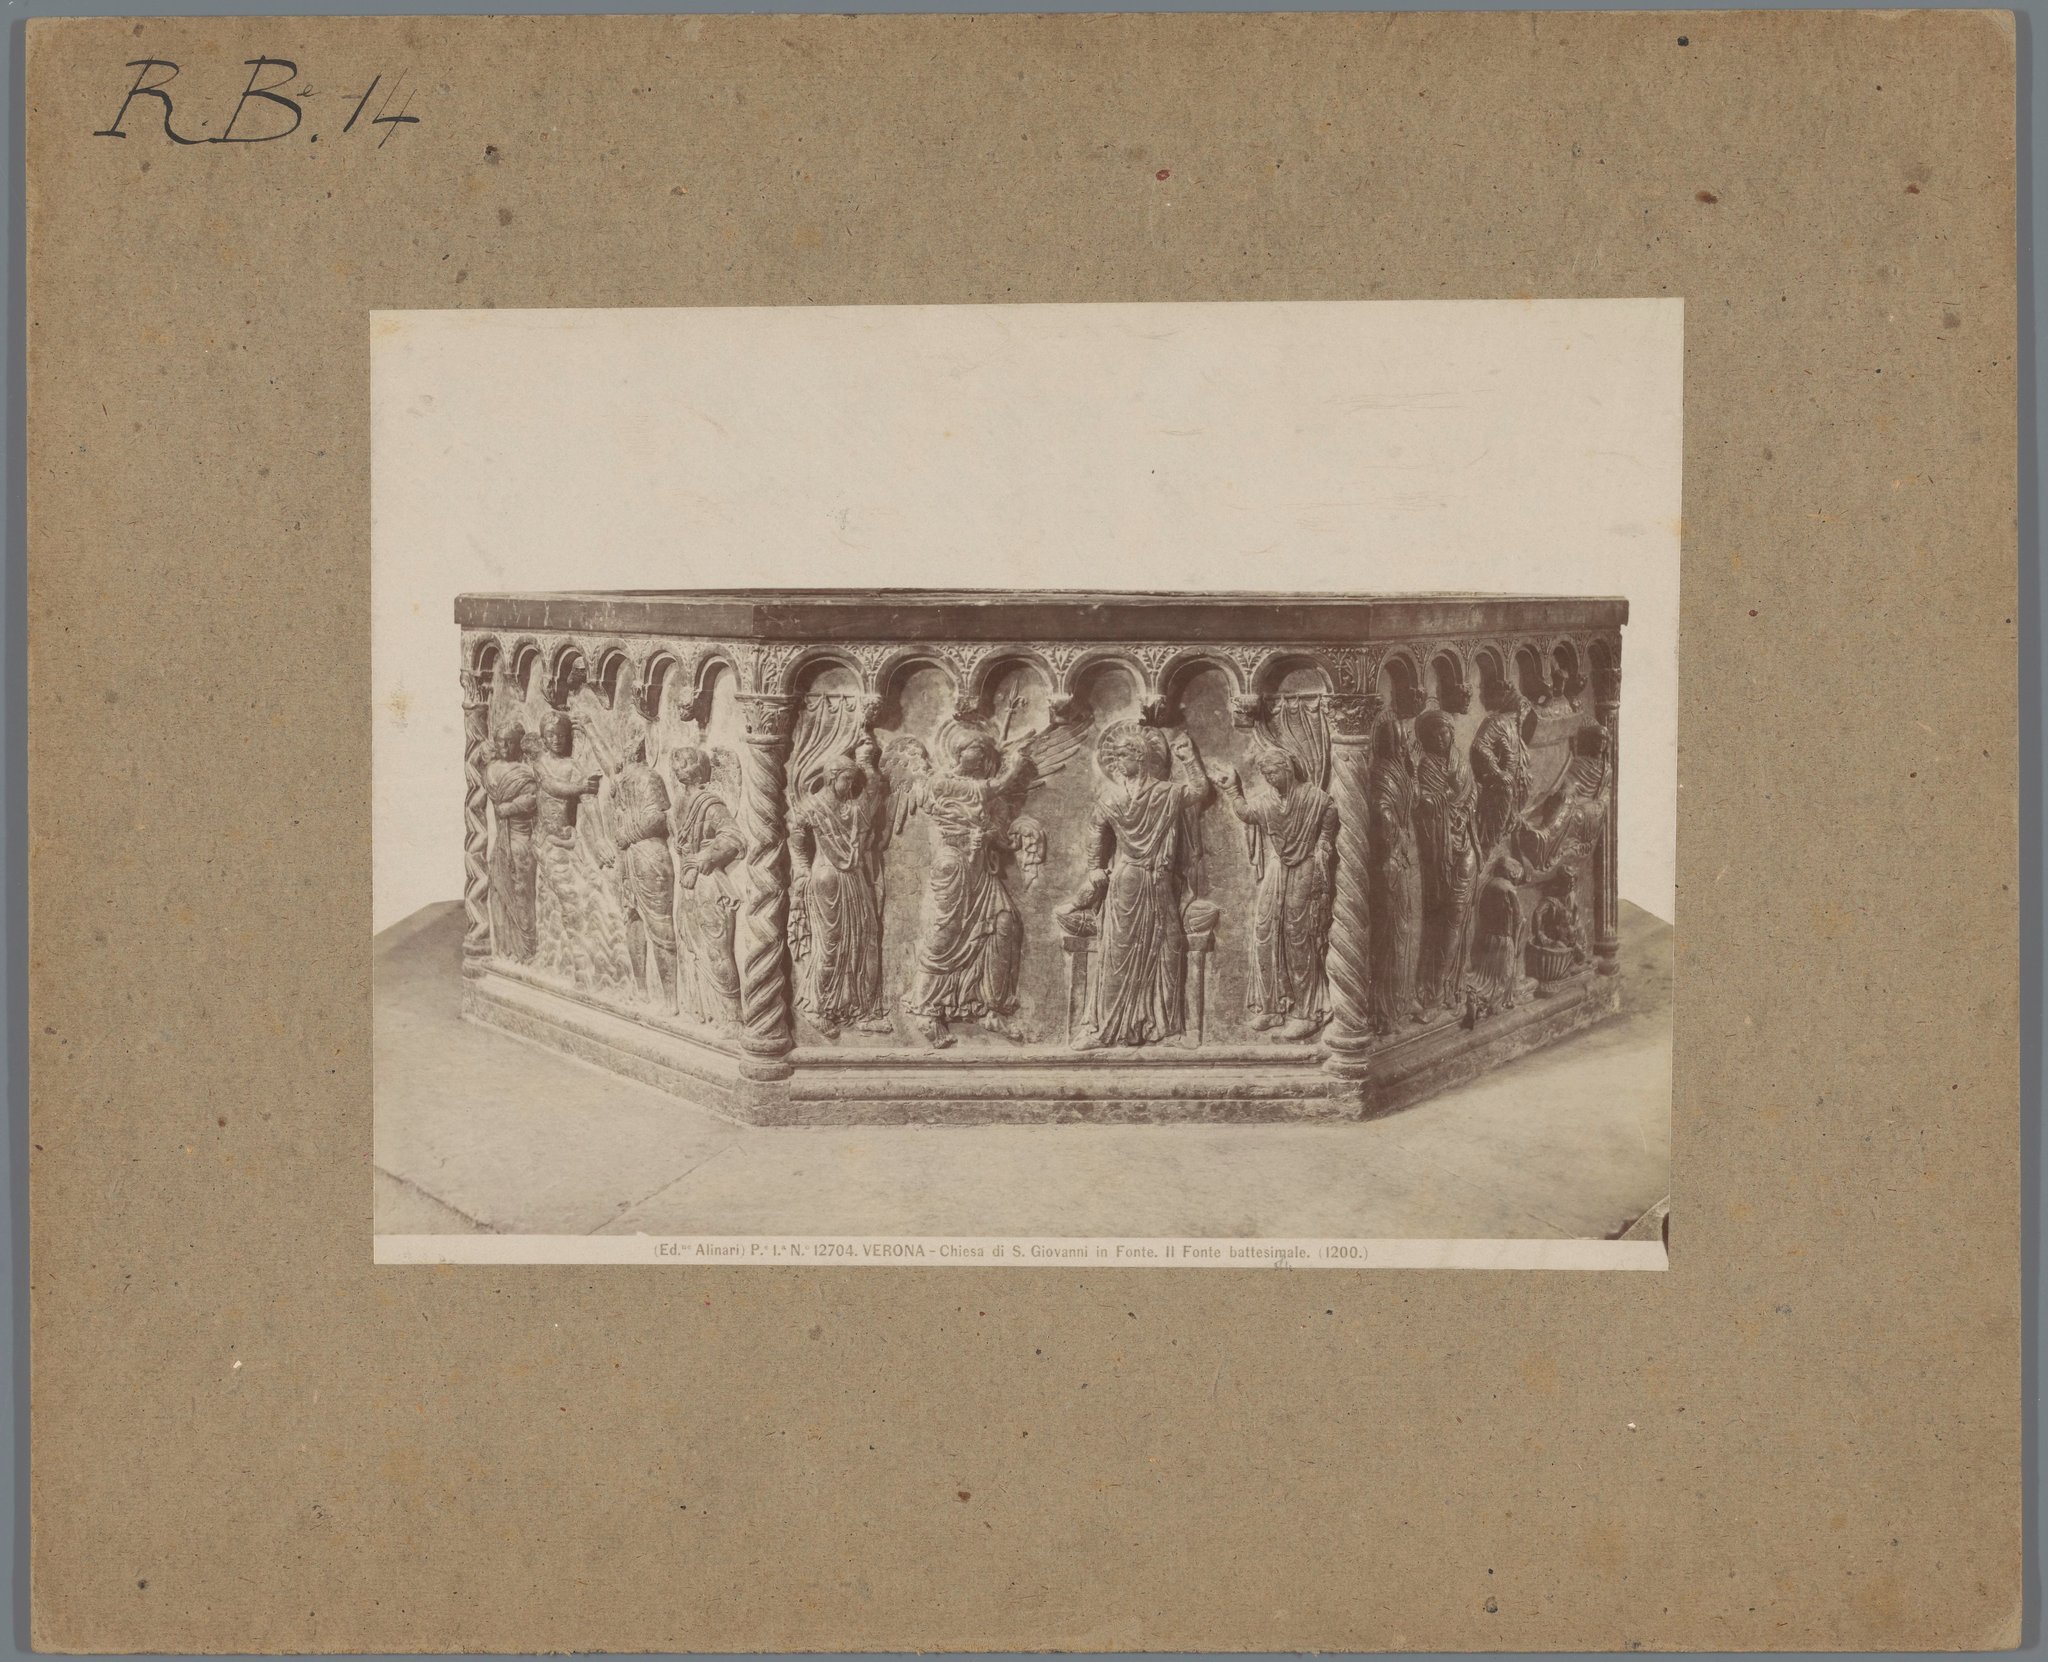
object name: photograph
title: VERONA - Chiesa di S. Giovanni in Fonte. Il Fonte battesimale. (1200.)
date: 1875-1900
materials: cardboard, photographic support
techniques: albumen print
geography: chiesa di san giovanni in fonte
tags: baptismal font, angels, sculpture (+ relief ~ sculpture)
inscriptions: collector's mark: Lugt 3937, inscription: ‘R.B-. 14.’, number: ‘P.e I.a N.o 12704.’